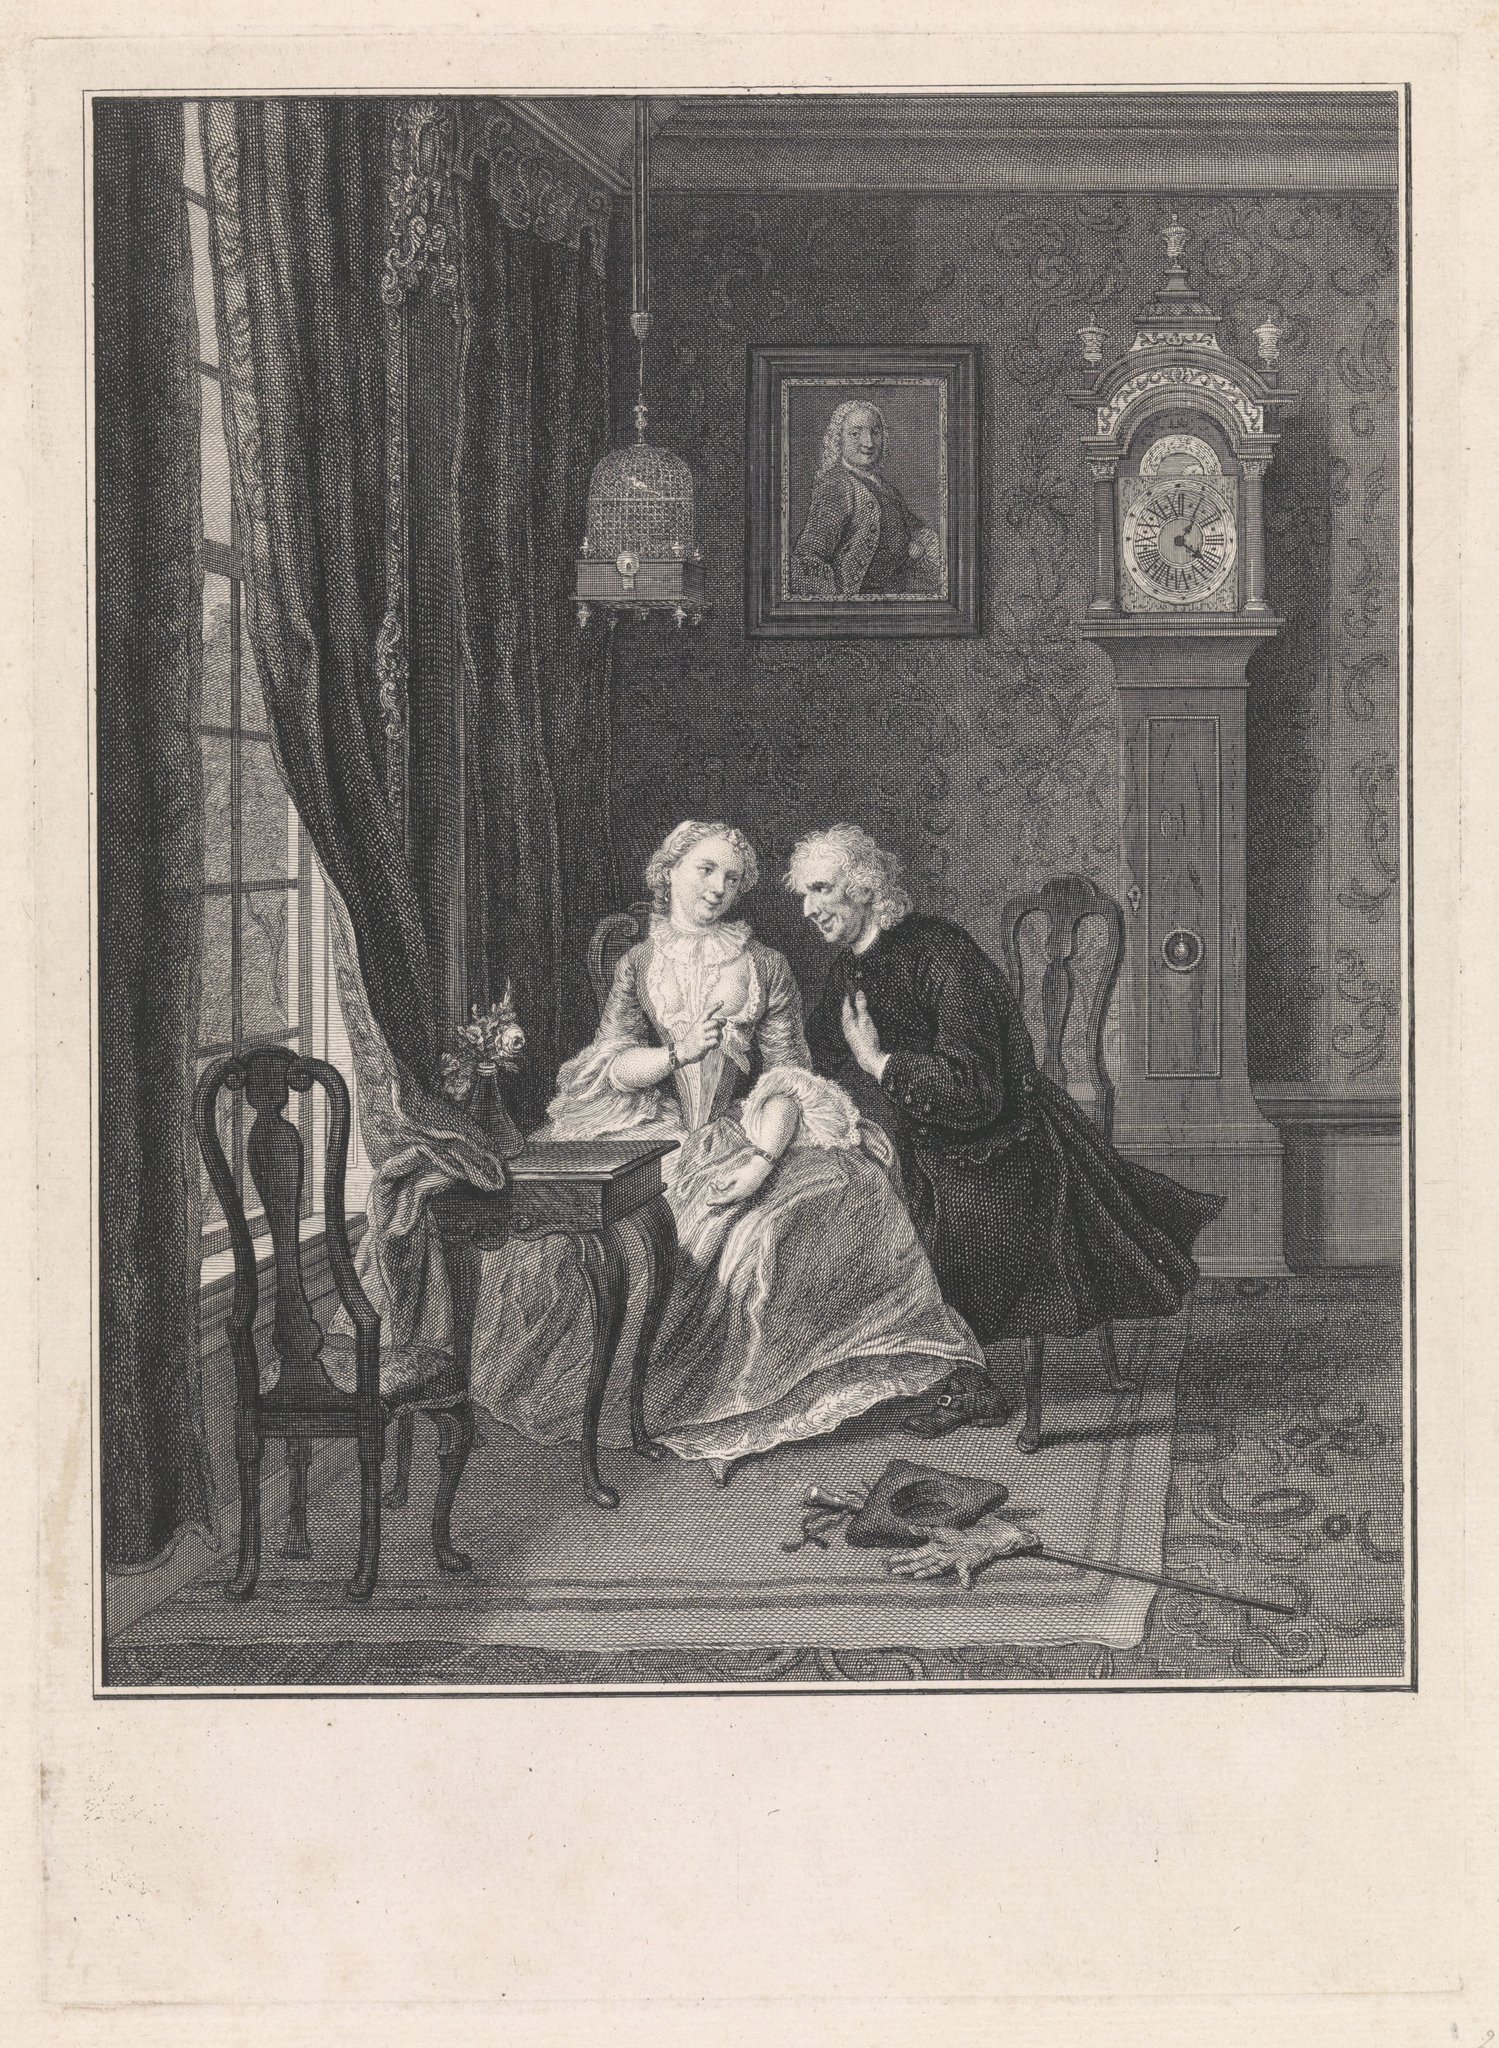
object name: print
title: De wanhebbelyke liefde / L'Amour mal assorti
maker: pieter tanjé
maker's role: draughtsman, print maker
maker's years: 1706-1761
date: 1752-1761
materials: paper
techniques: engraving, etching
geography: amsterdam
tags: unequal couple, ill-matched couple, living-room, parlour, sitting-room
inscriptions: collector's mark: Lugt 240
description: Joost, een oude weduwnaar en de vader van Lucia's geliefde, bekent aan Lucia zijn liefde. Scène uit het toneelstuk De wanhébbelyke liefde, van Philippe Quinault.